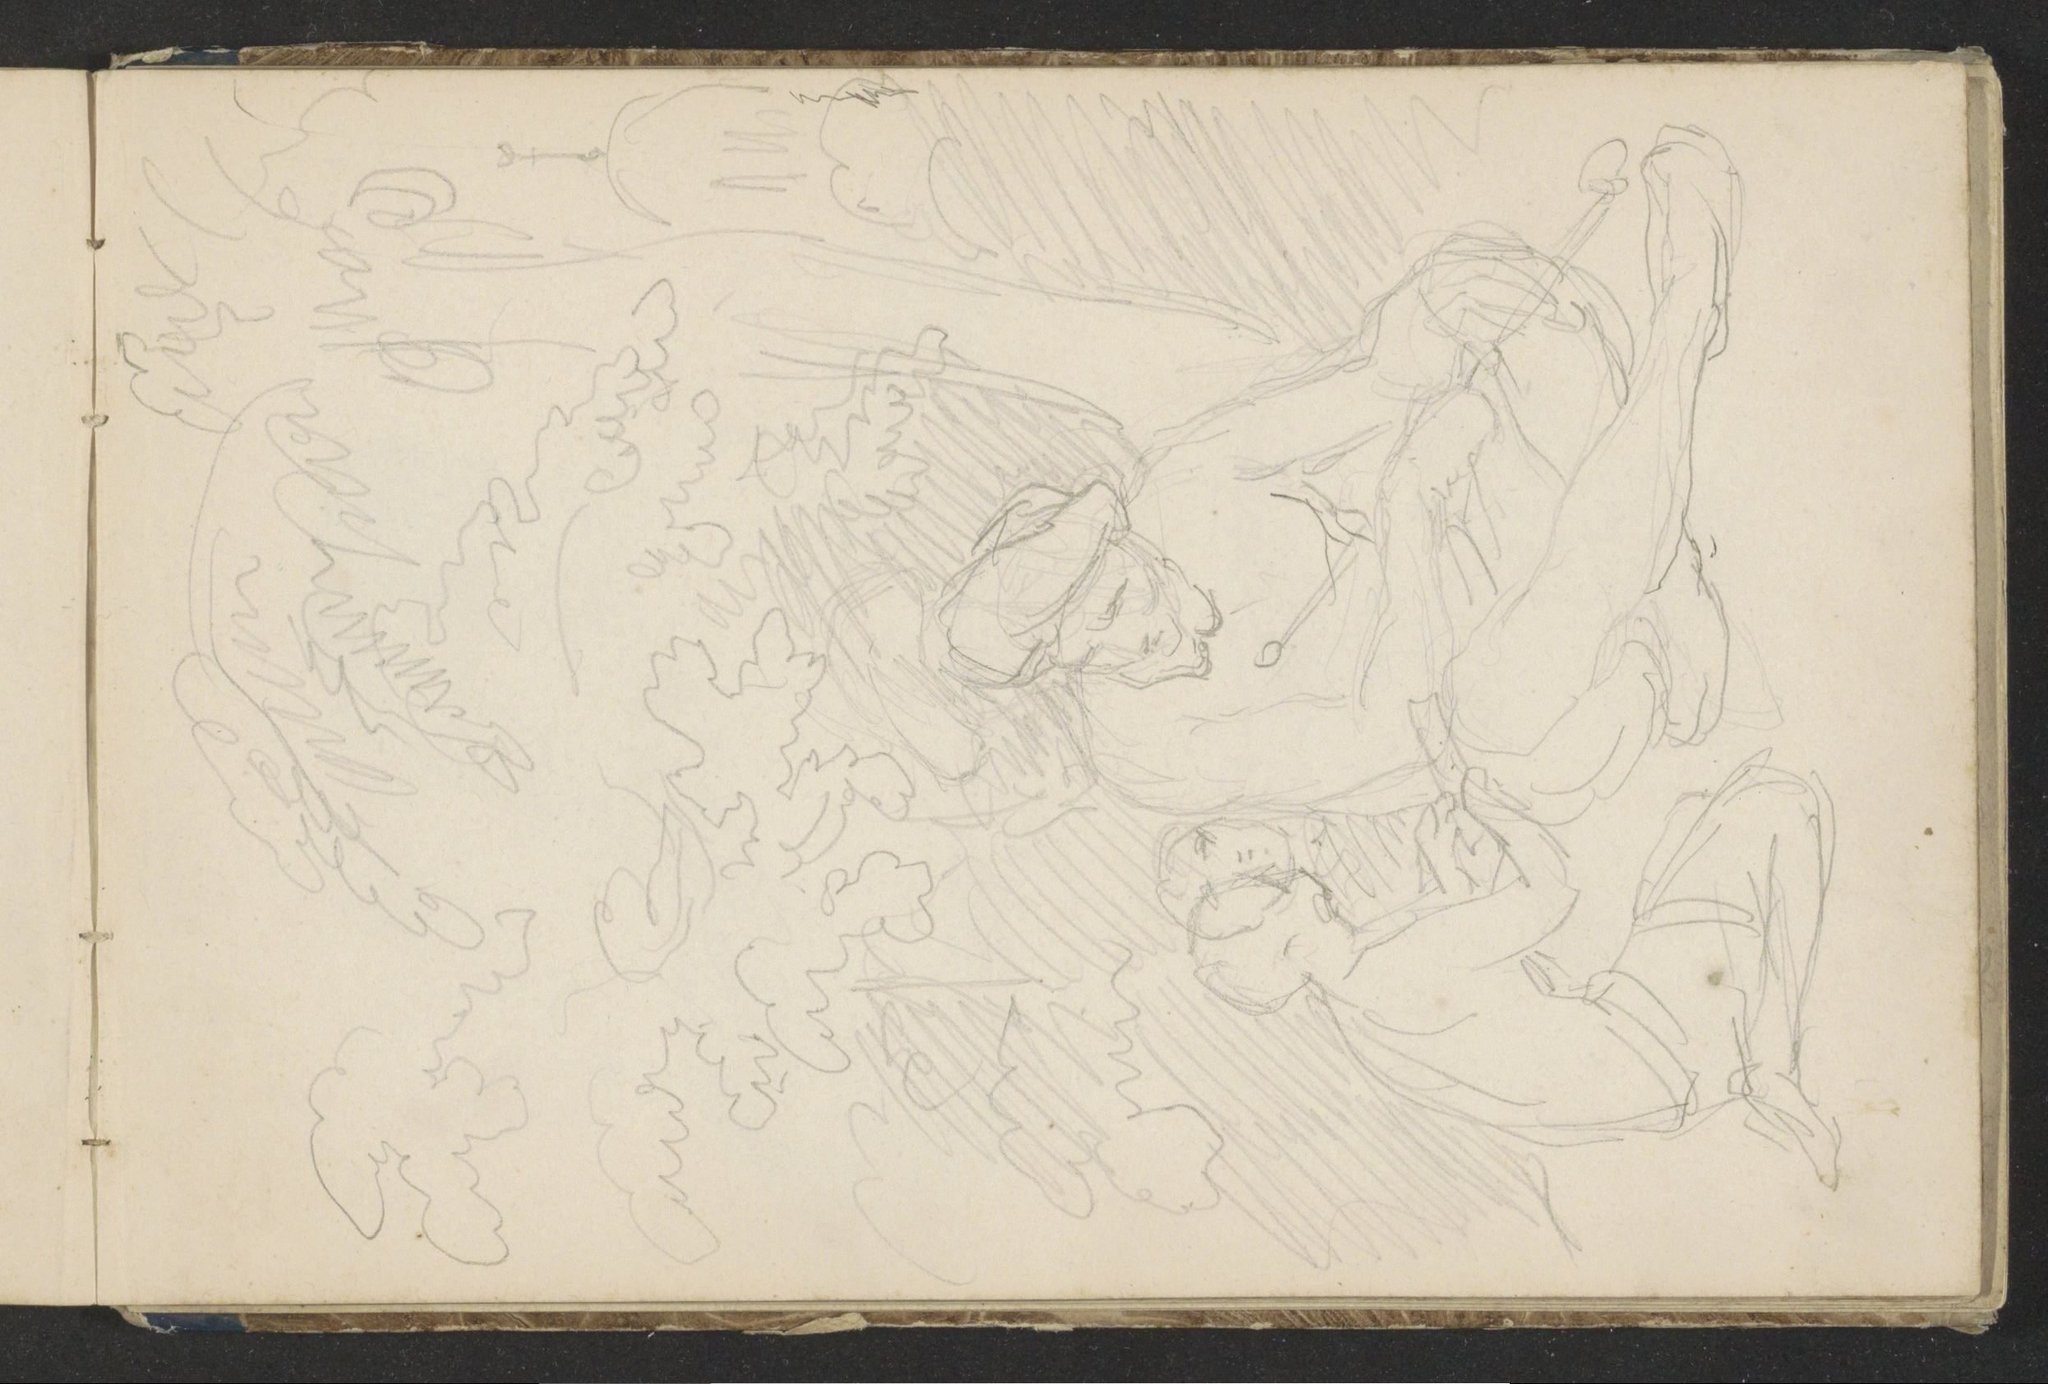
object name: sketchbook leaf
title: Man met tulband zittend onder een boom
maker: Anonymous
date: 1841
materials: paper, pencil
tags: sitting figure, head-gear: turban, kneeling figure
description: De man heeft een baard en zit met de benen gekruist onder een boom. Hij draagt een doek om zijn middel en heeft een staf in de hand. Naast hem knielt een jongen met een voorwerp in de handen. Blad 10 recto uit een schetsboek met 33 bladen.